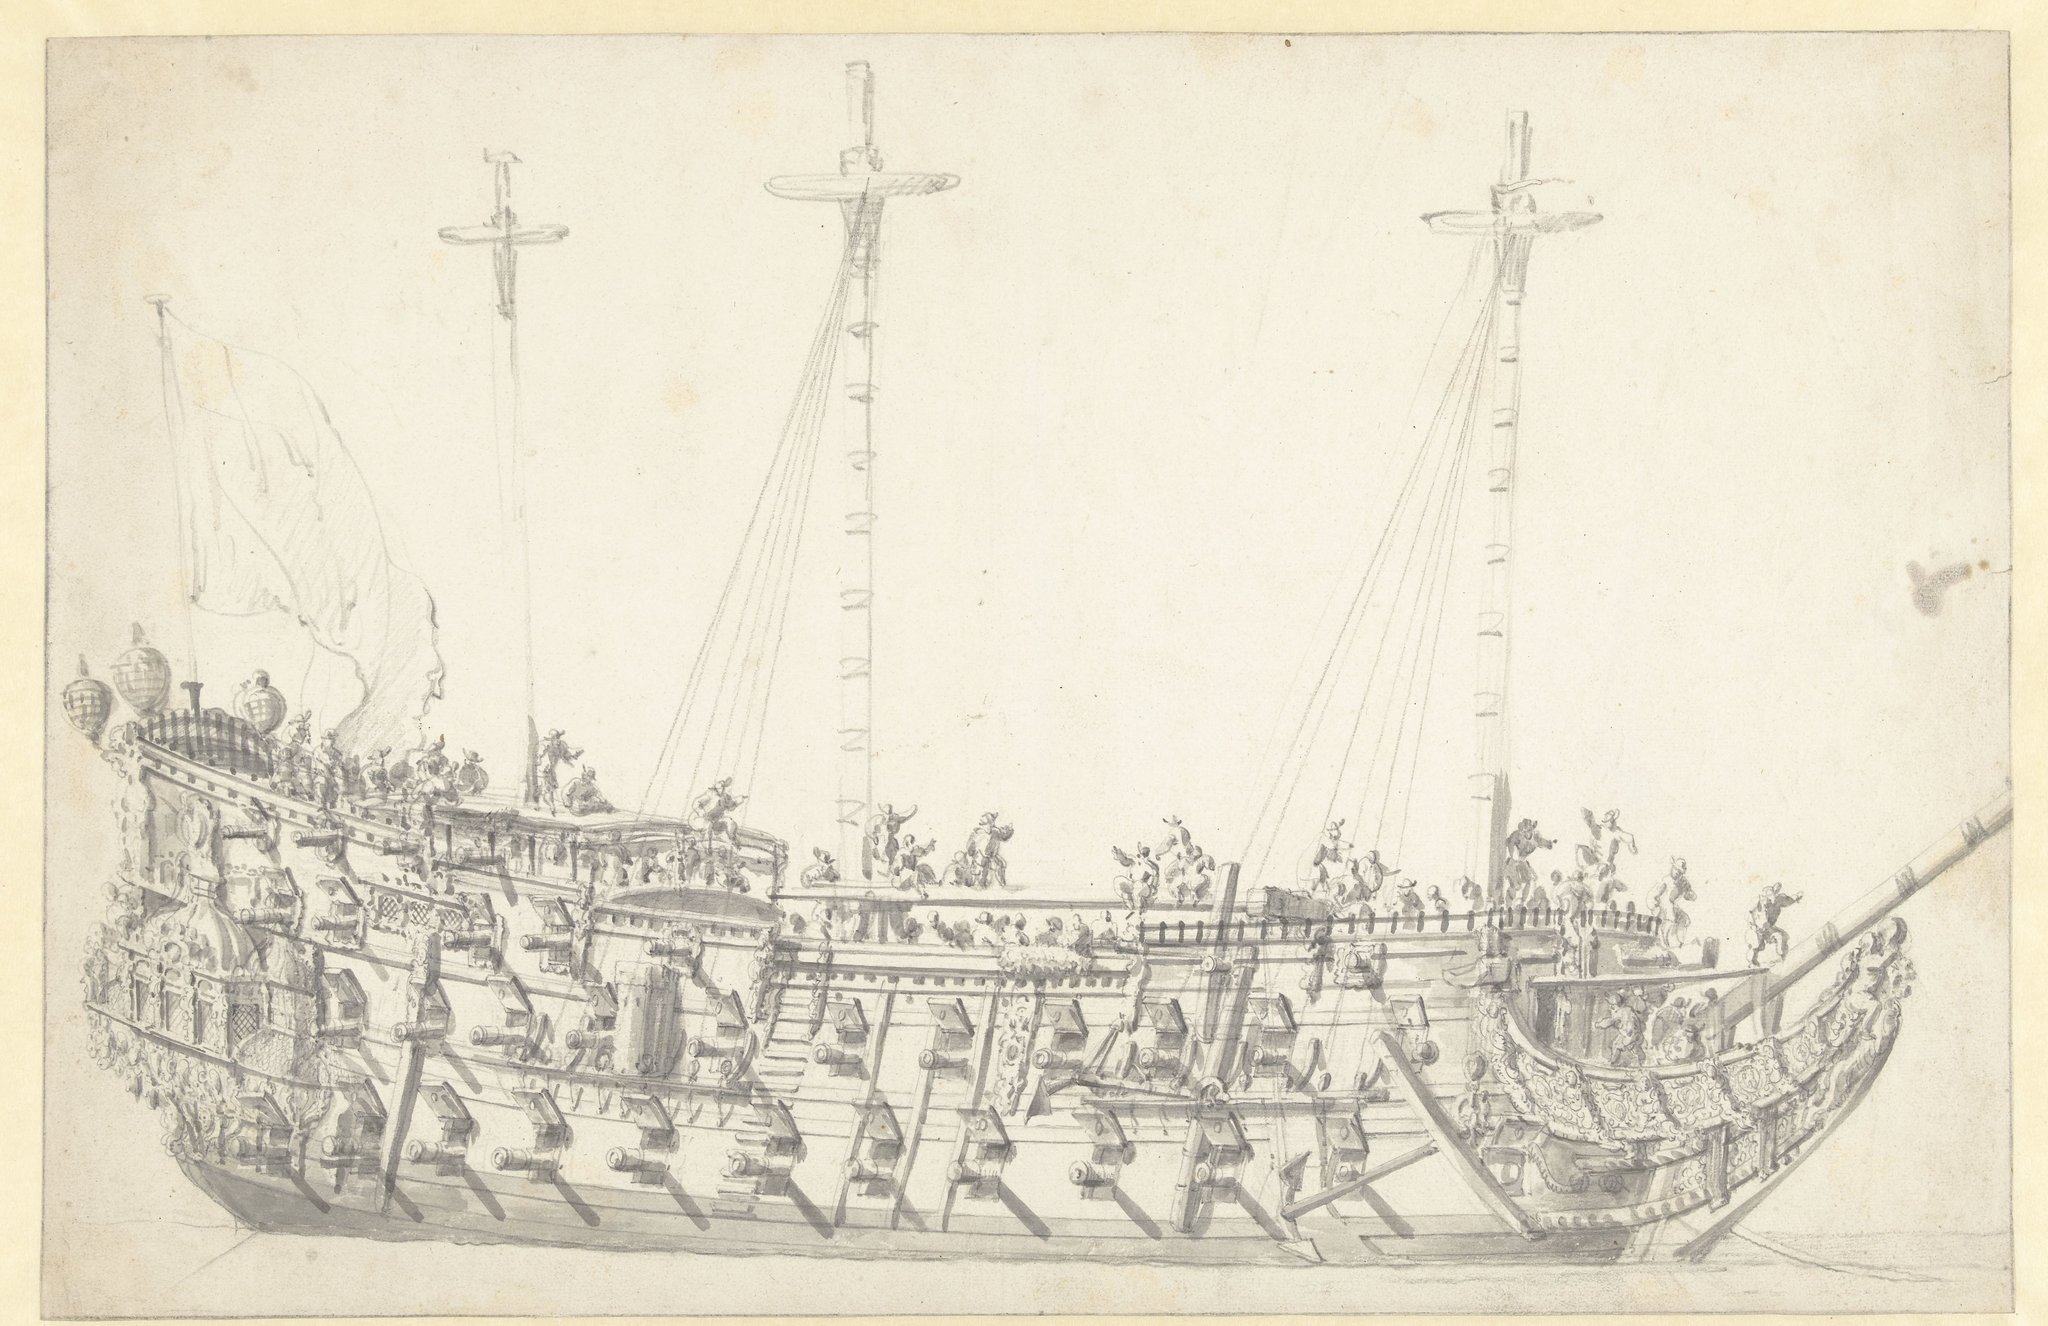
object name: drawing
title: Man-of-War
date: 1622-1707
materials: paper, pencil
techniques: brush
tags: sailing-ship, sailing-boat, navy (+ sailing-ships)